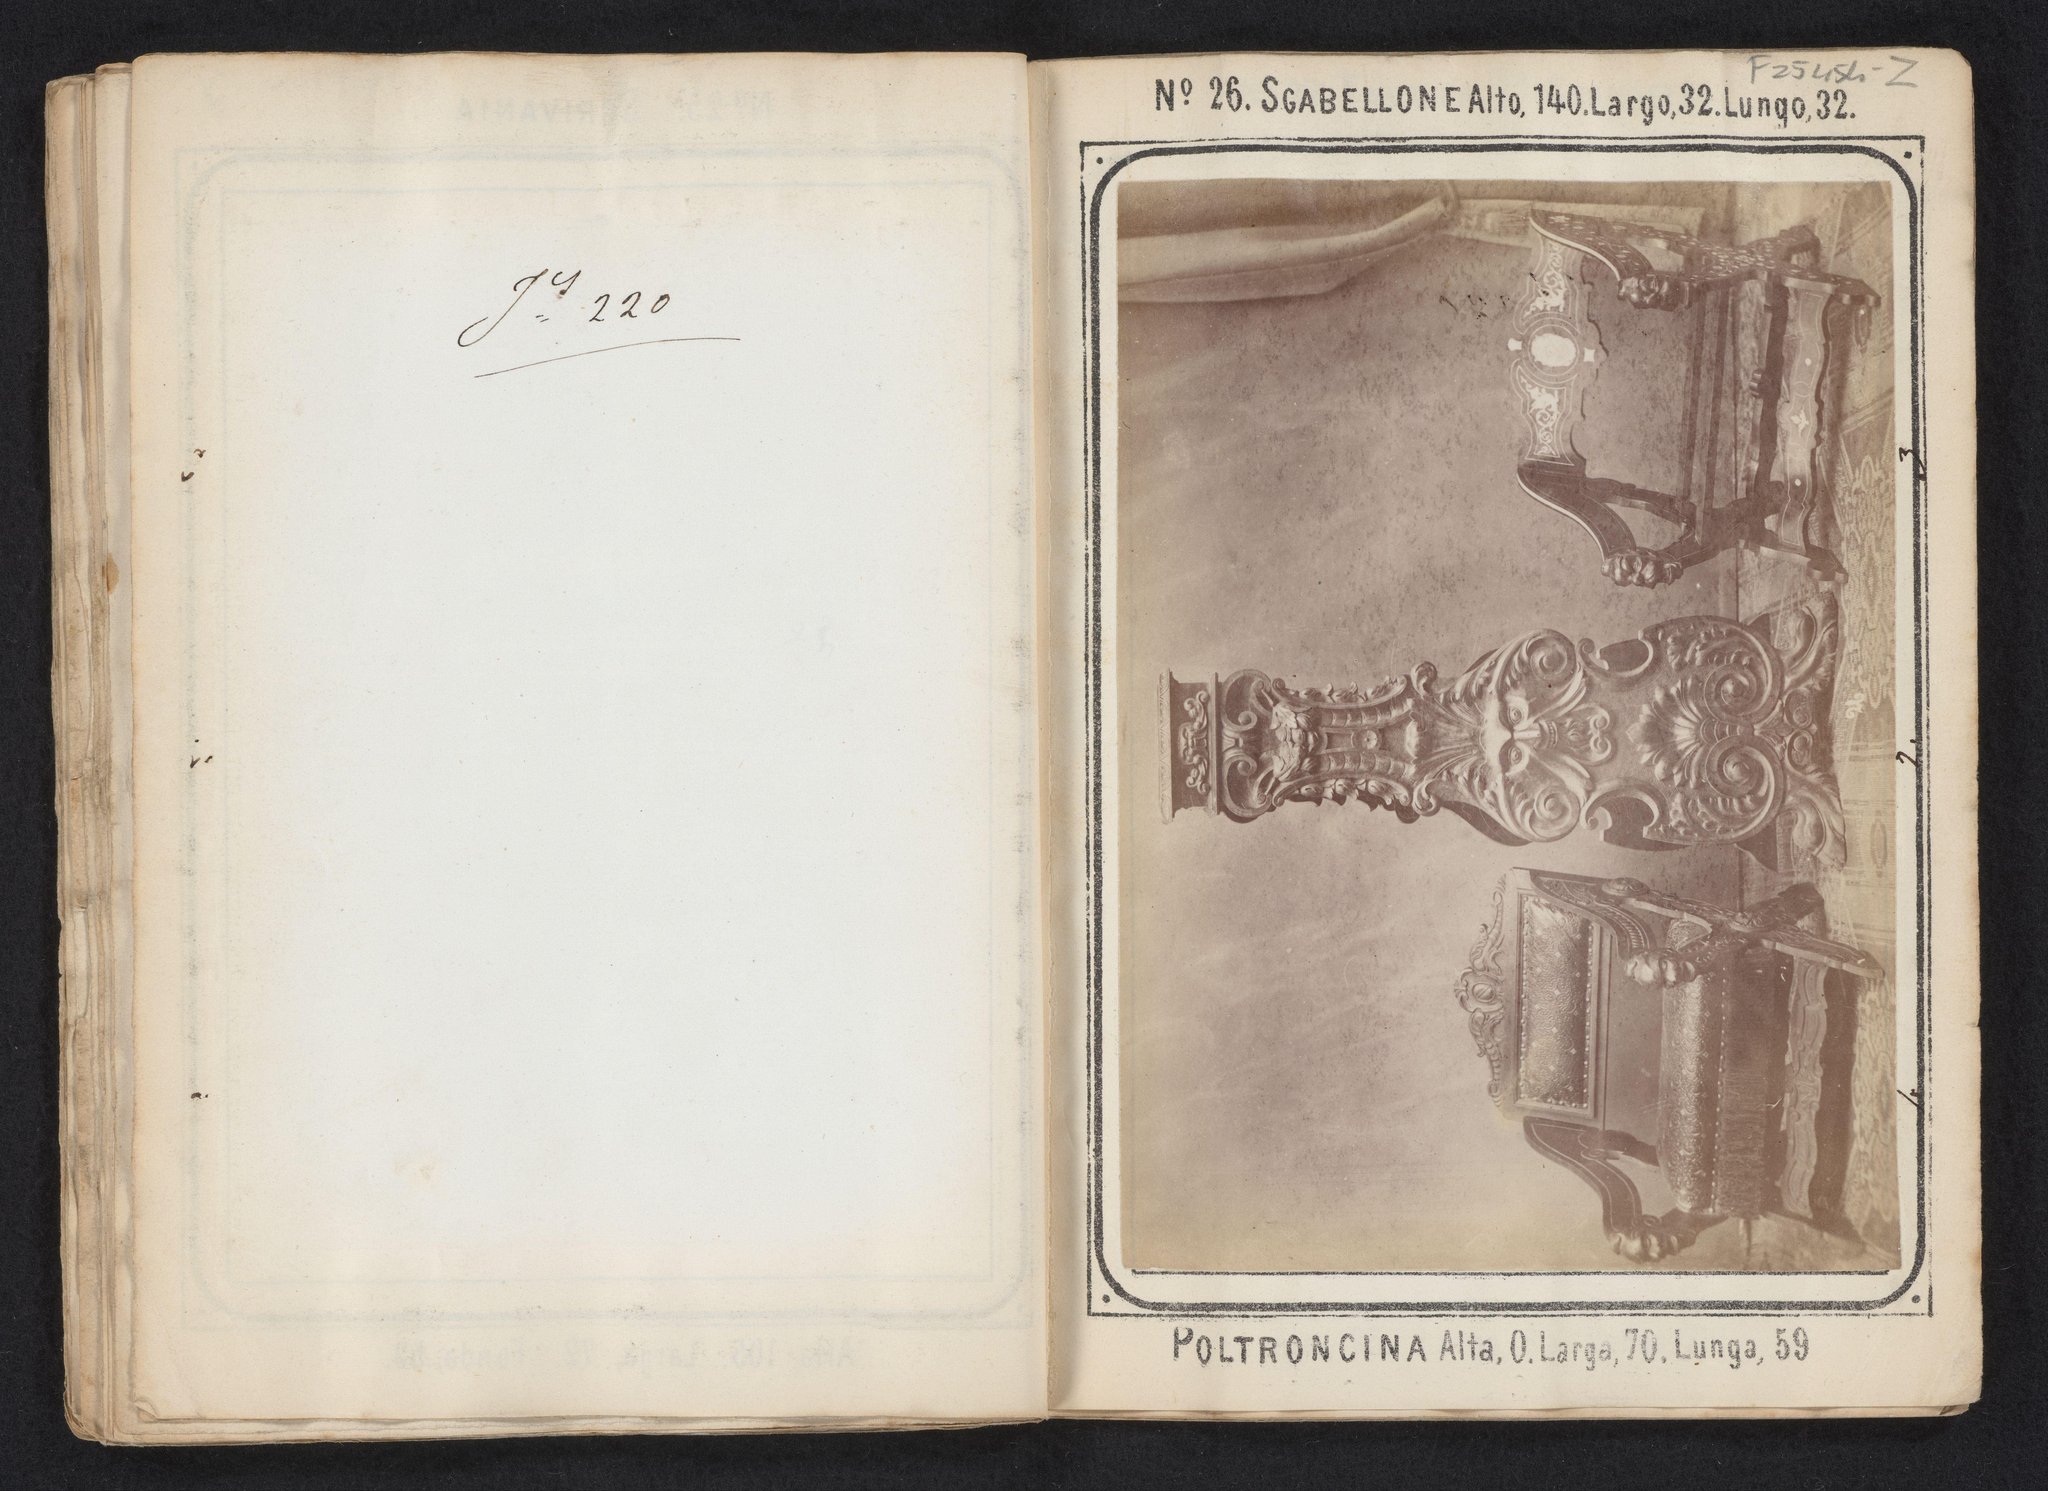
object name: page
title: No 26 Sgabellone, Poltroncina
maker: Anonymous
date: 1878-1885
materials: paper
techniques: albumen print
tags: chair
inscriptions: inscription: ‘Alto, 140. Largo, 32. Lungo, 32./ Alta, 0. Larga, 70. Lunga, 59’, inscription: ‘No. 1. Ies. 40/ " 2. 90 la paire/ " 3. 55’, number: ‘1. 2. 3.’